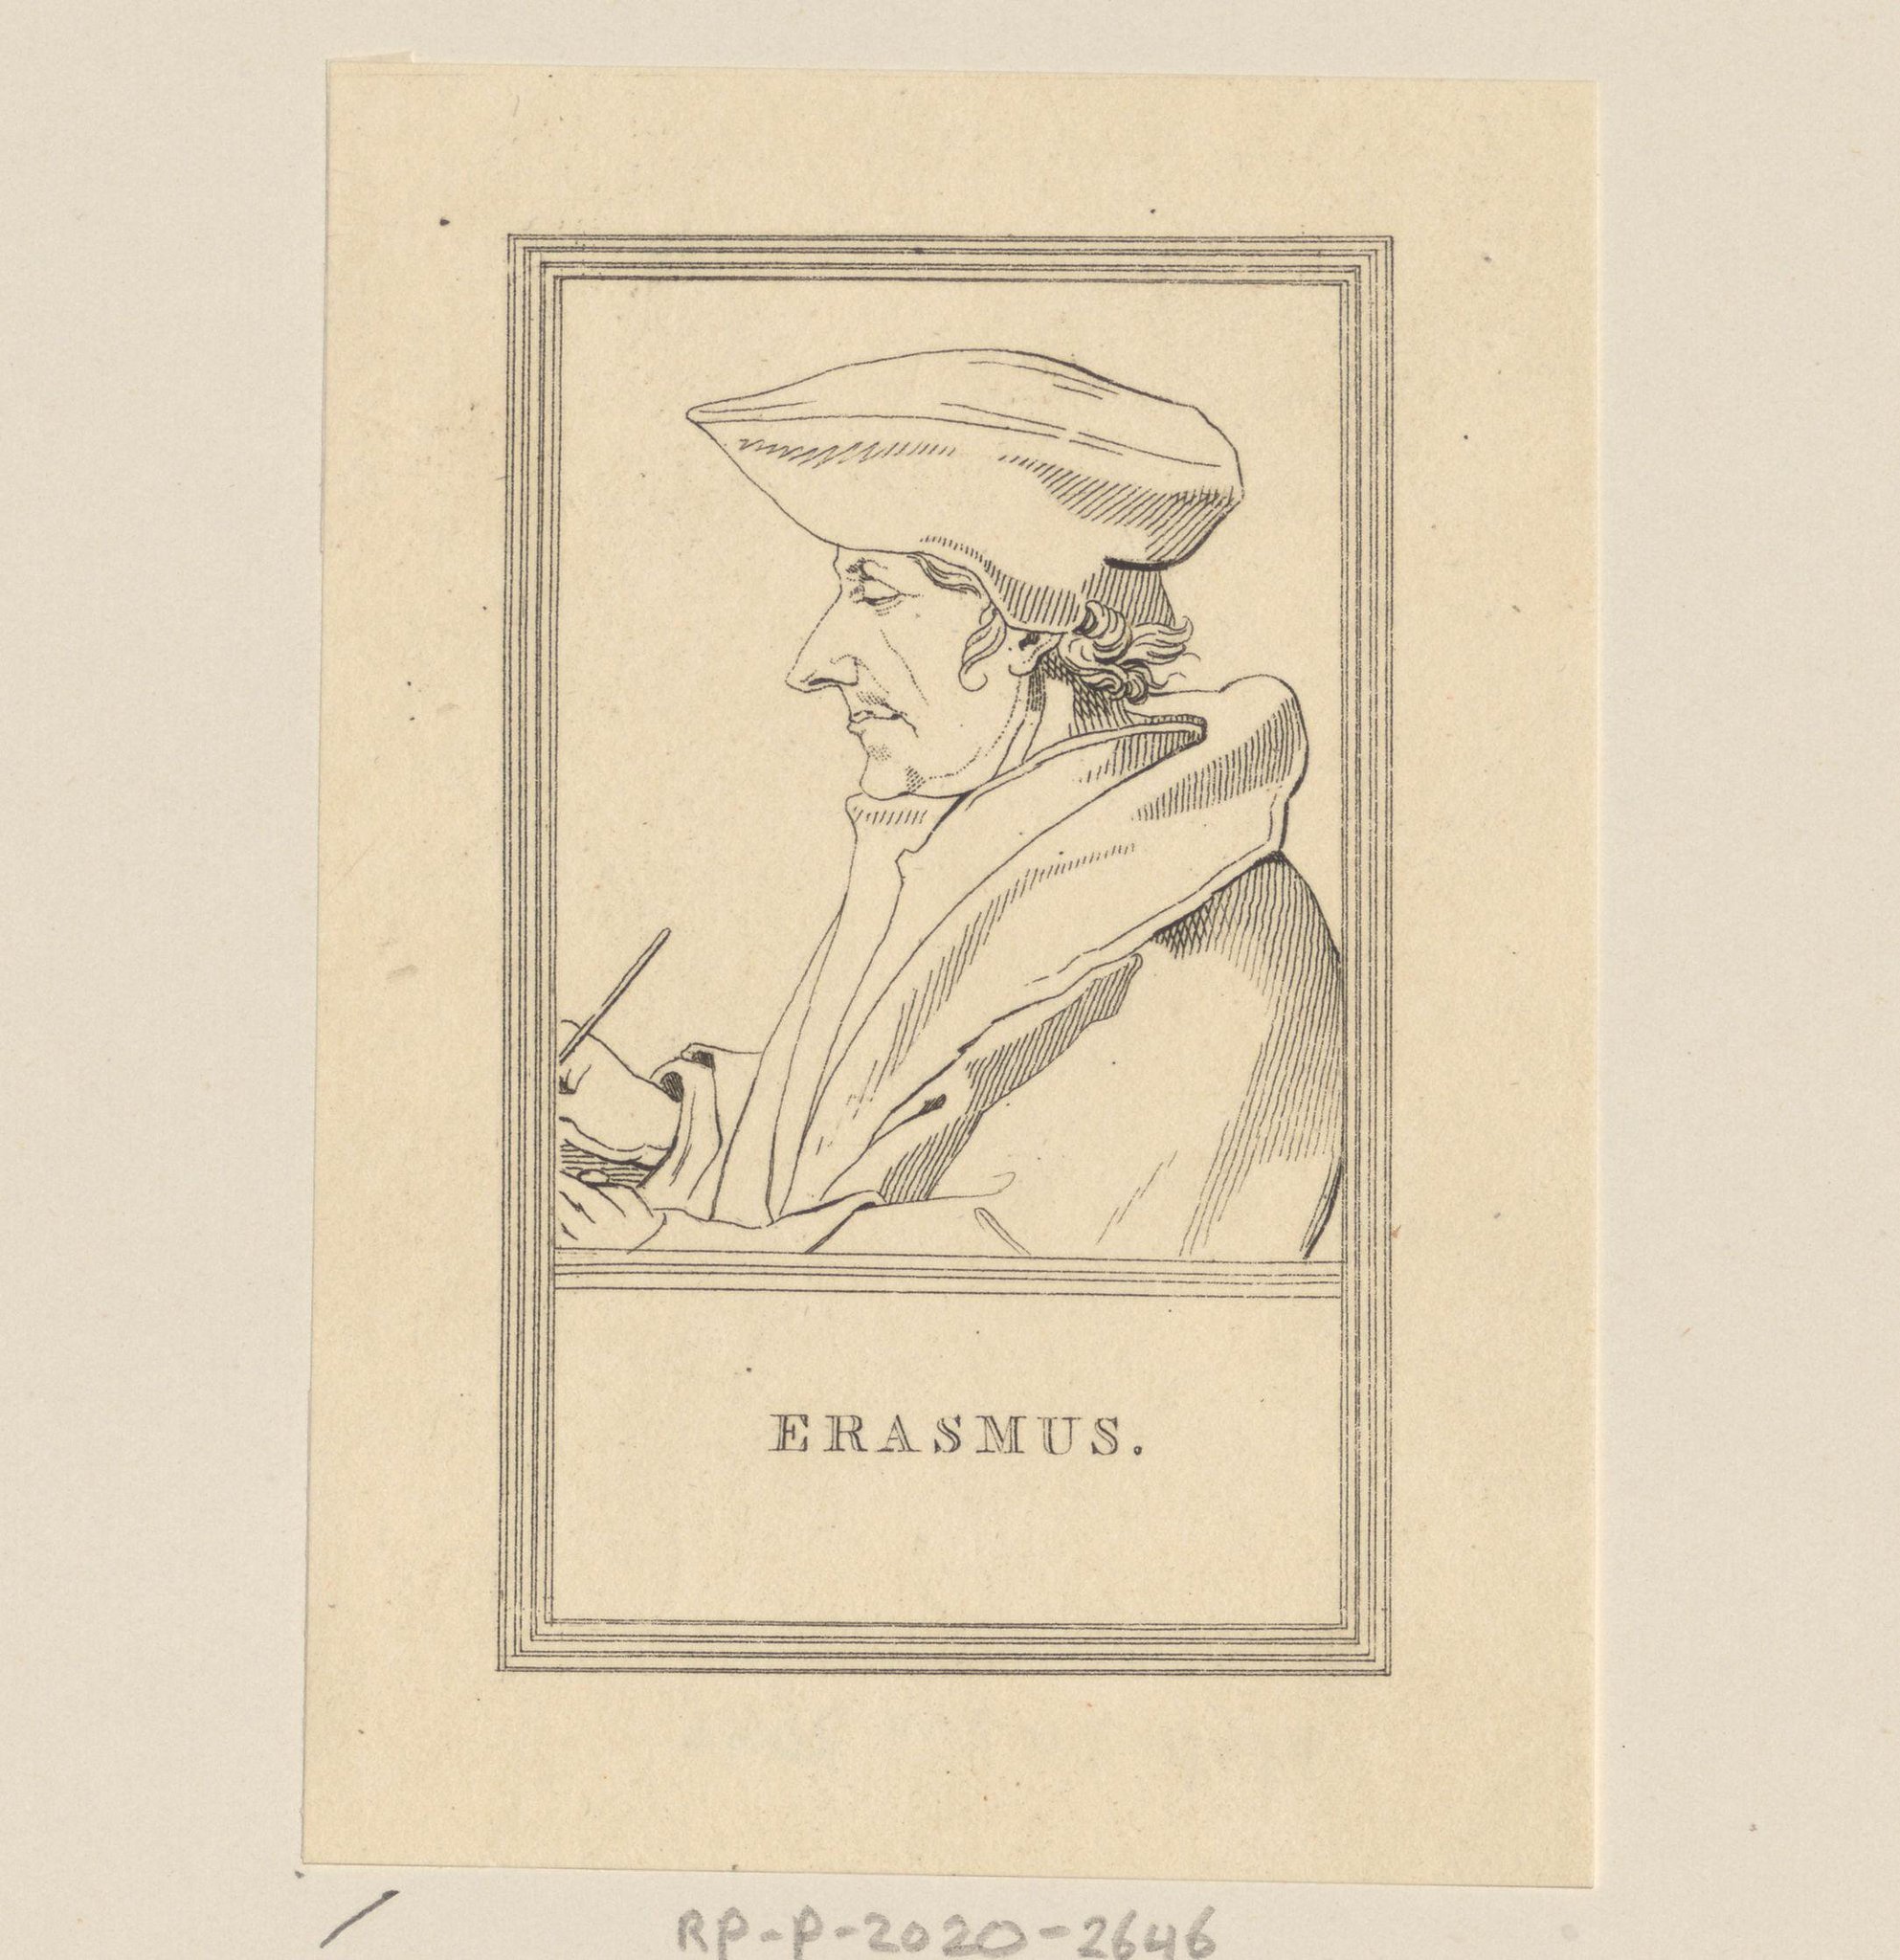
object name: print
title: Portret van Desiderius Erasmus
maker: Anonymous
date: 1805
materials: paper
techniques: etching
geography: france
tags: rotterdam, desiderius erasmus, historical persons, scholar, philosopher (+ portrait of scholar, scientist)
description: Prent in latere staat gebruikt in: Galerie historique des hommes les plus celebres de tous les nations (...). Parijs: Charles Paul Landon, 1805, dl. 5.